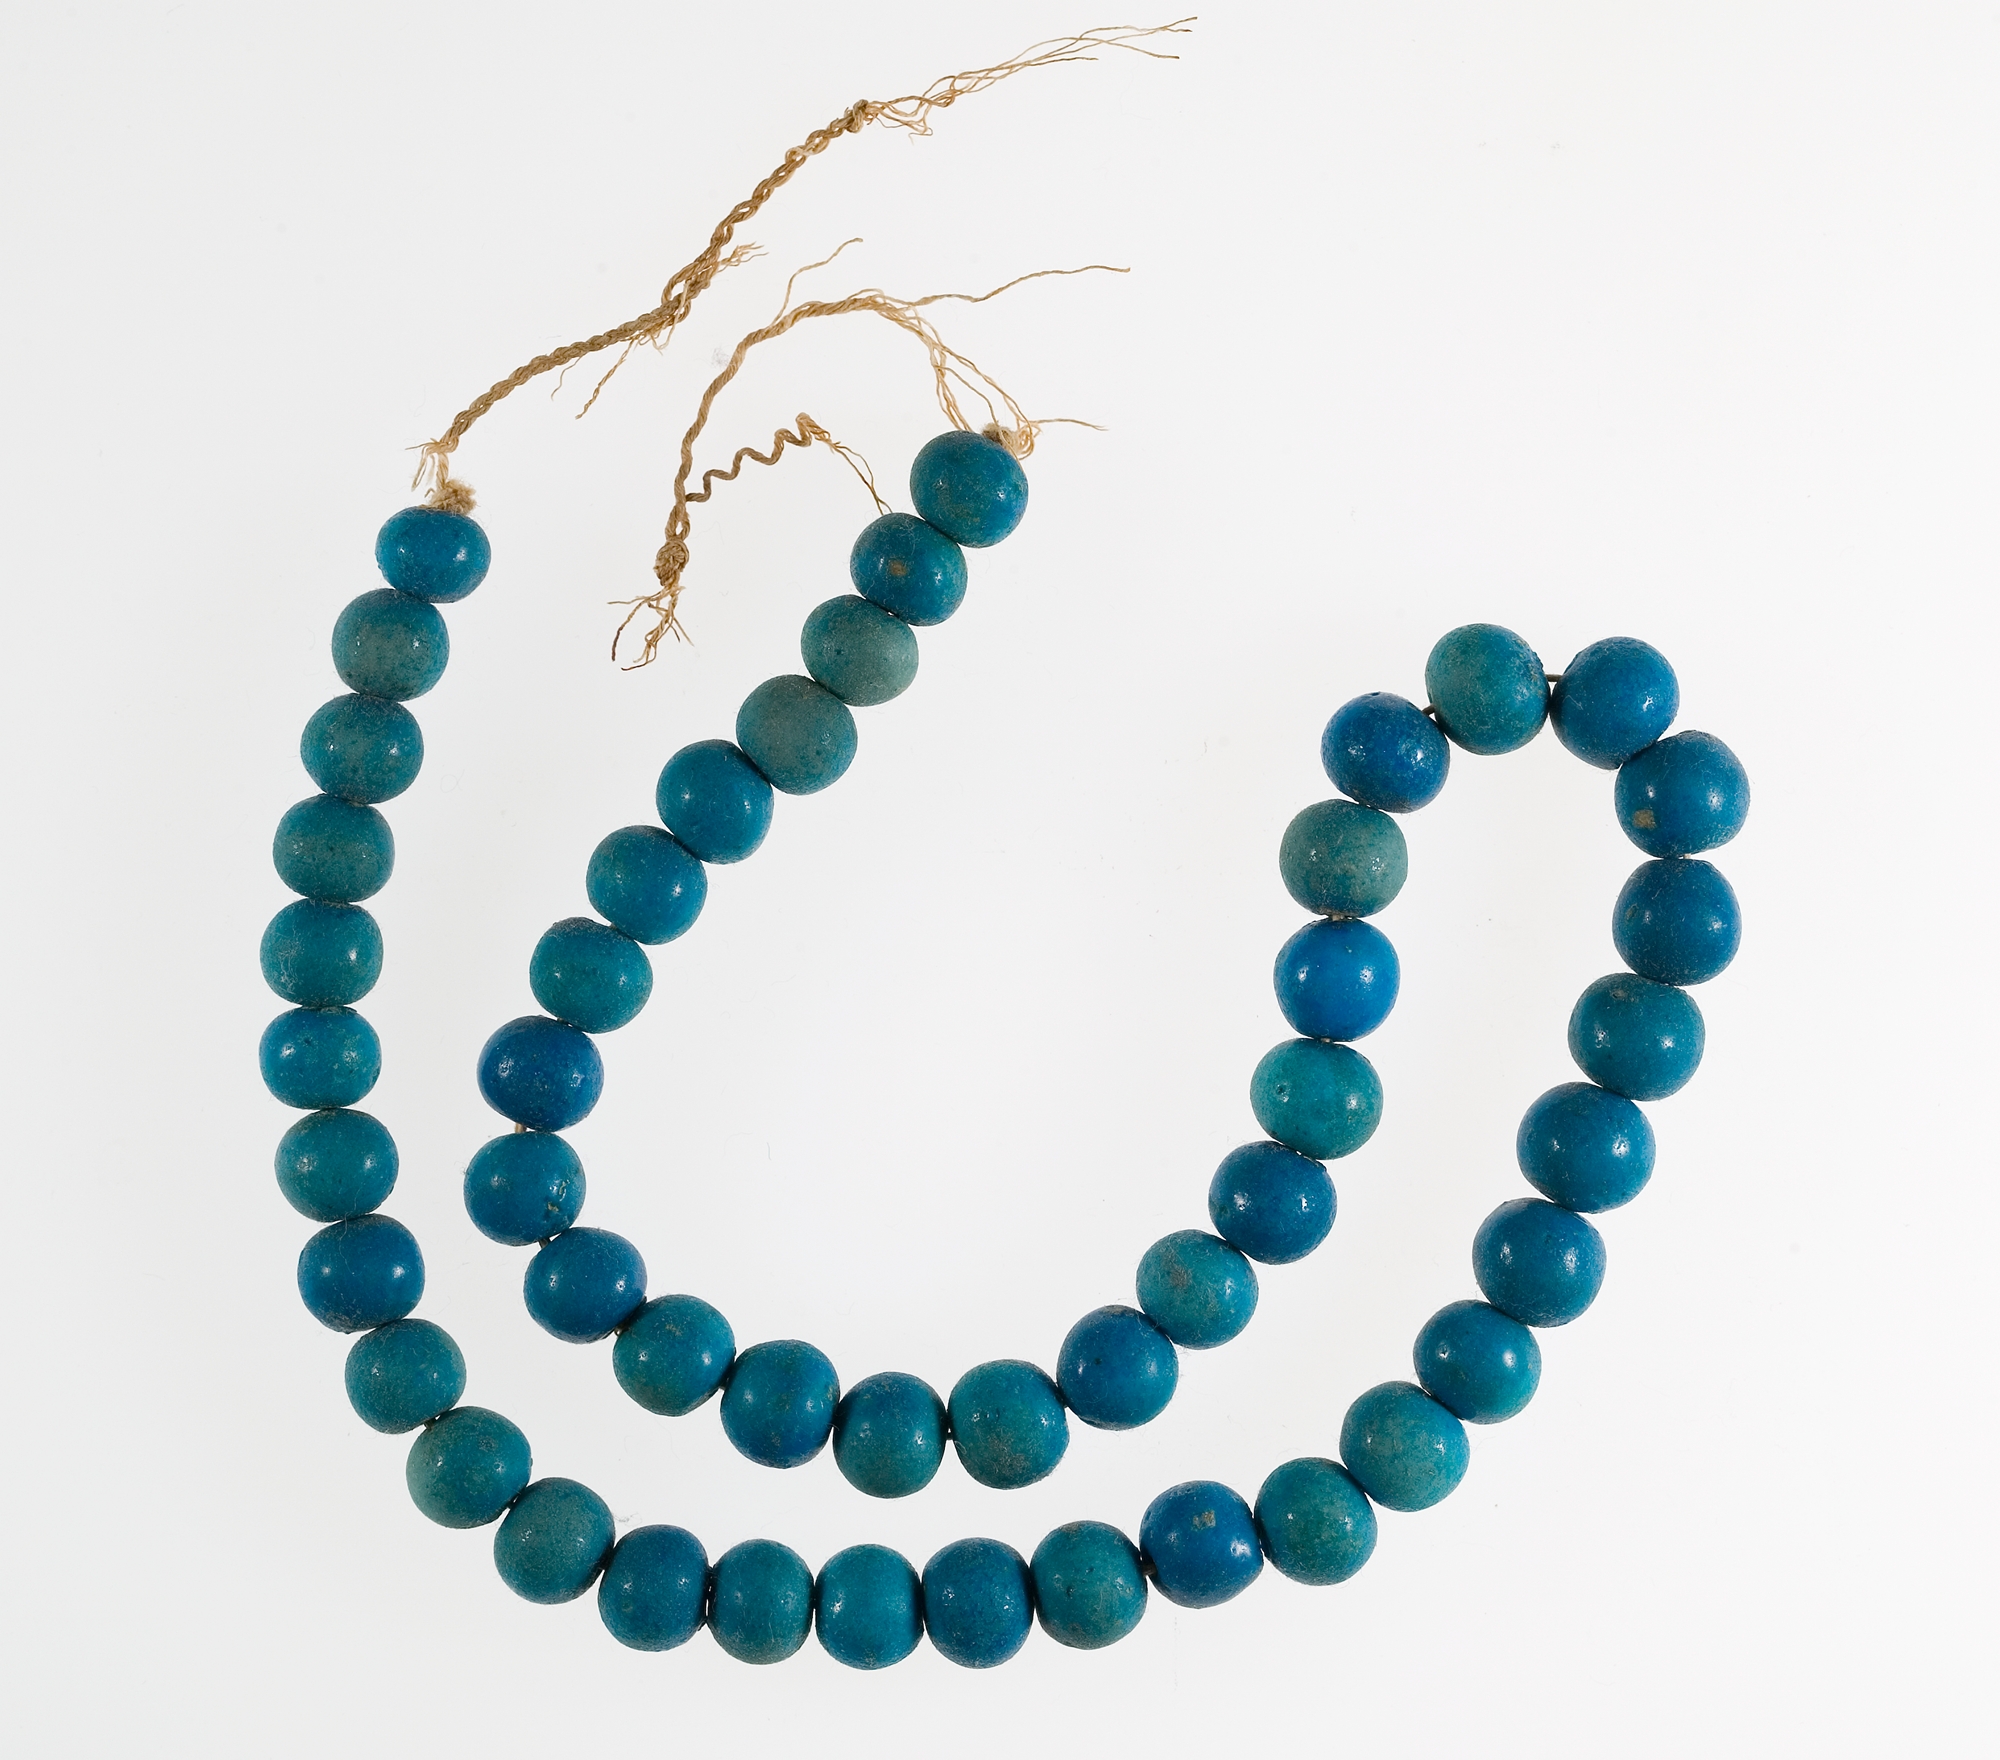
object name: necklace, wah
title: Necklace of Wah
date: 1981-1975 BCE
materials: cord, faience, linen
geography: egypt